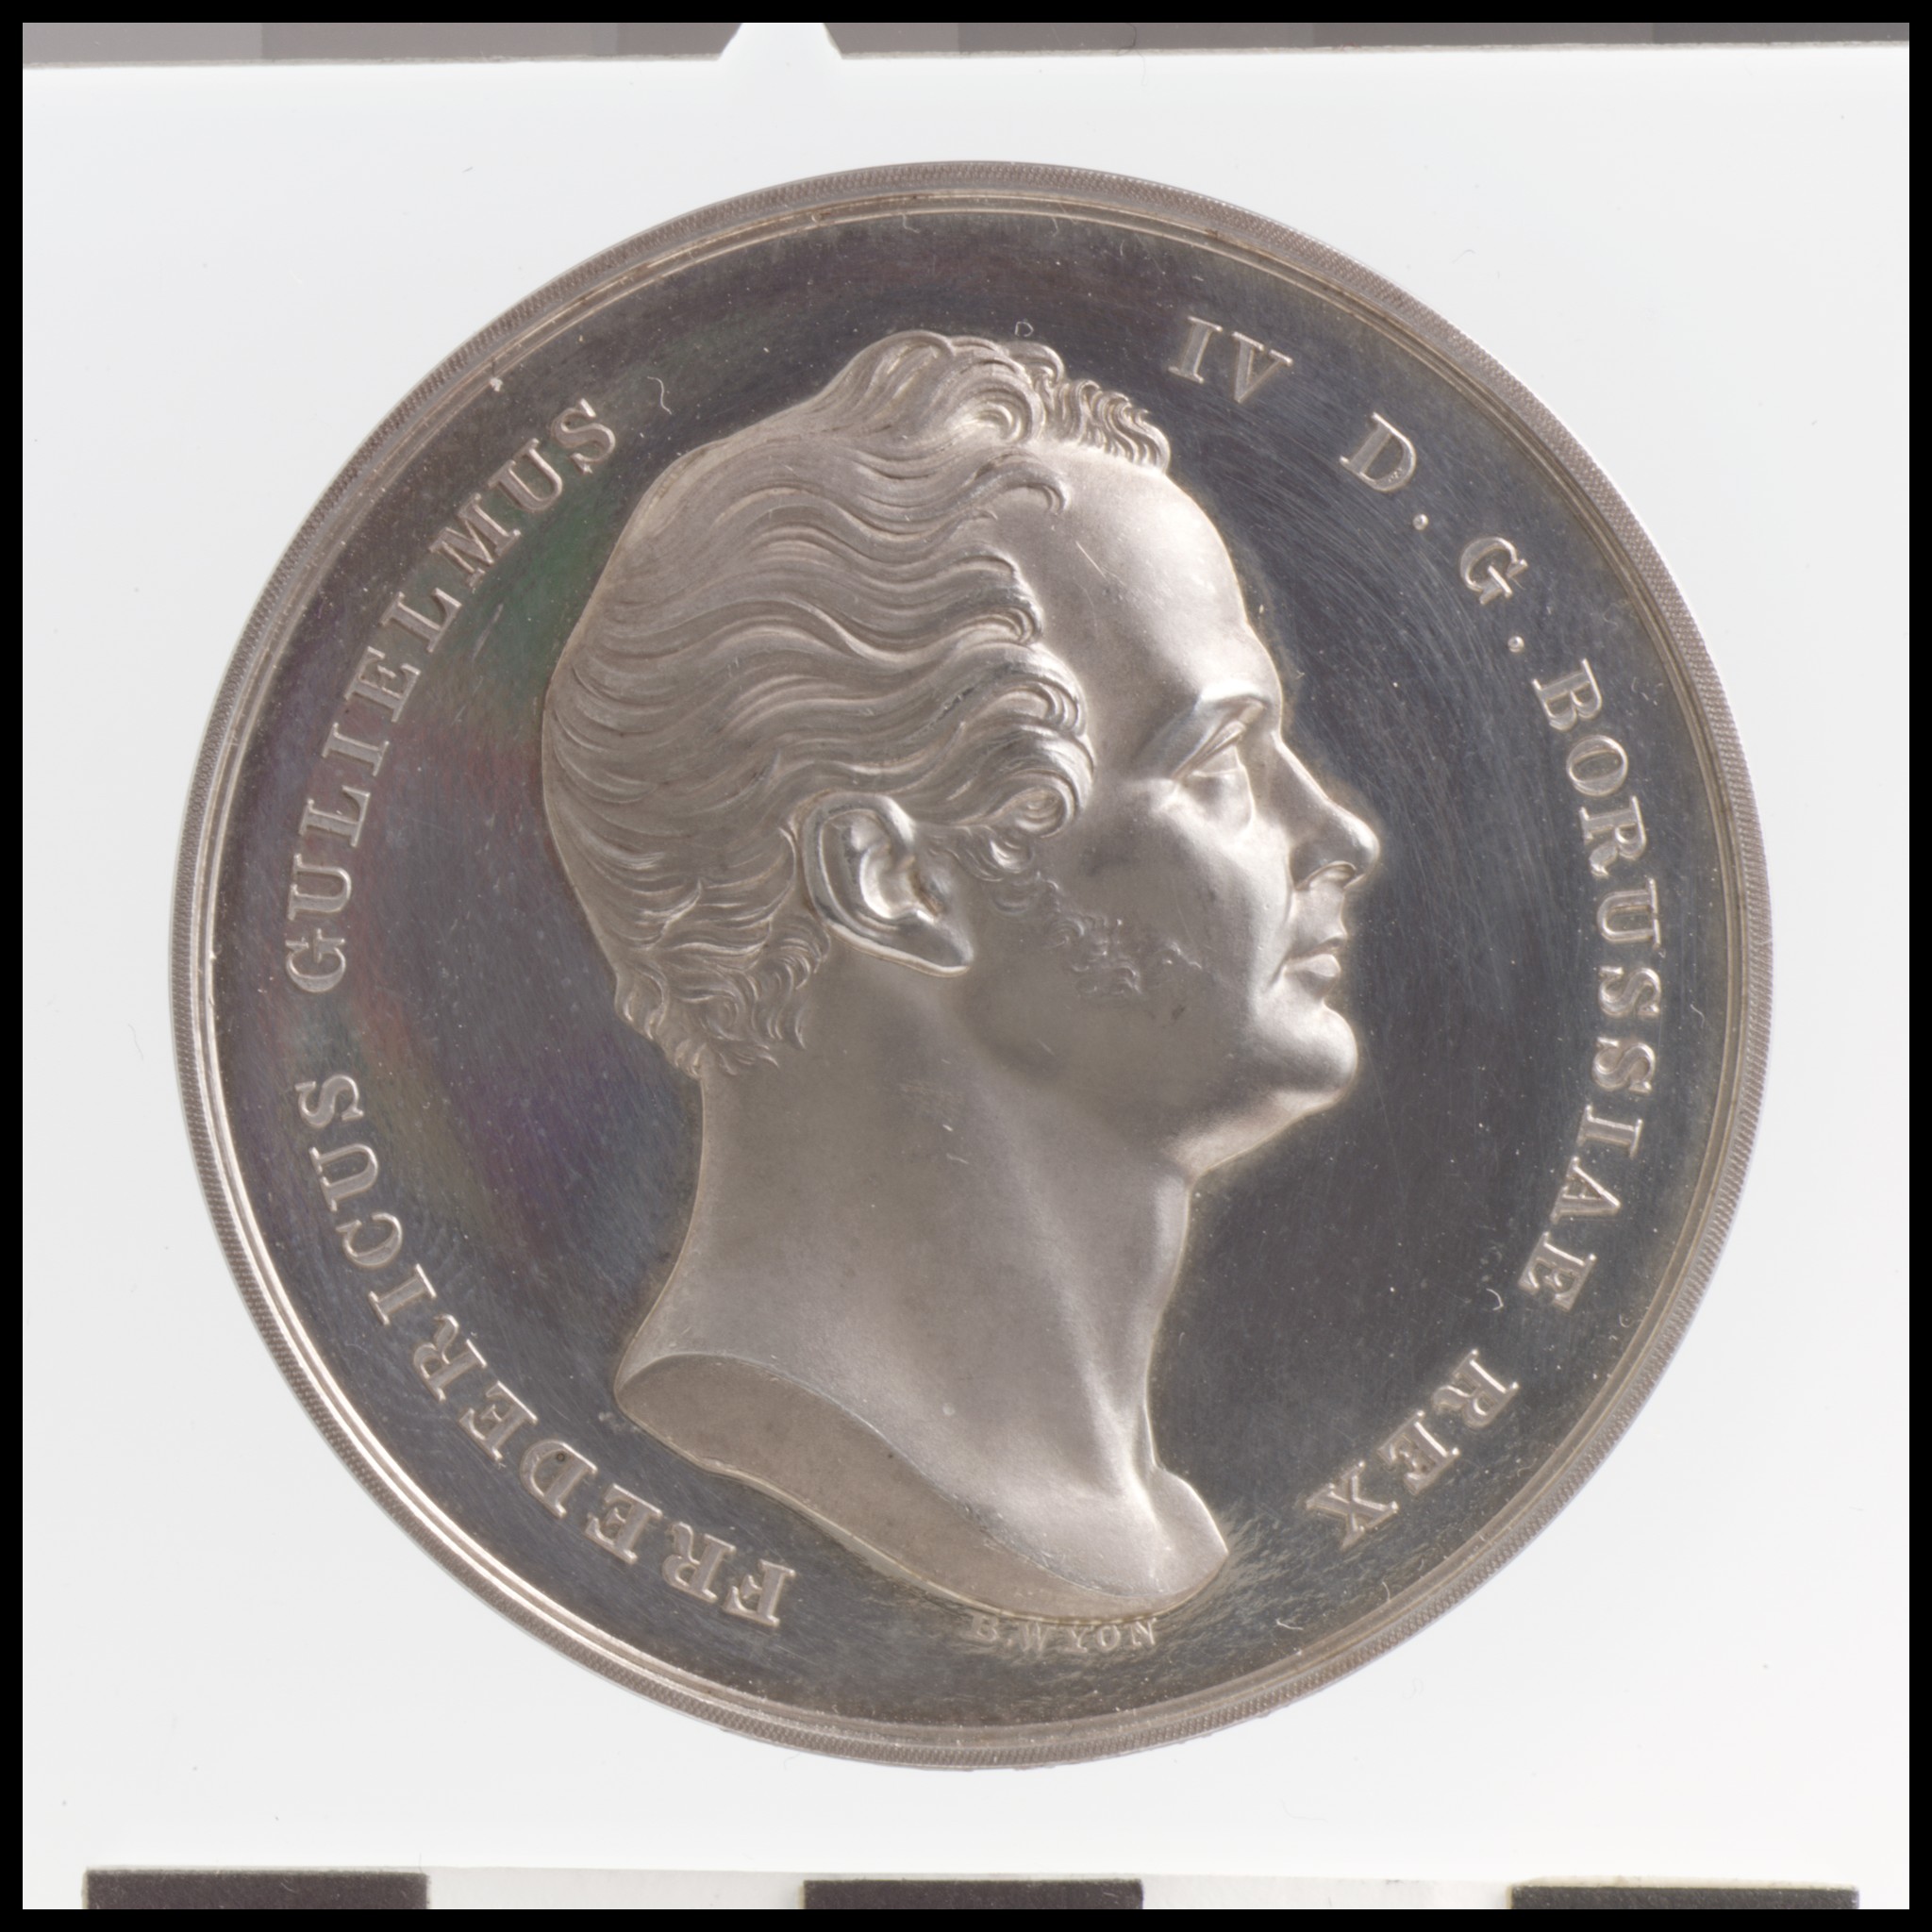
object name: medal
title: Friedrich Wilhelm IV's Visit to London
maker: benjamin wyon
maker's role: artist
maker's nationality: british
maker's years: 1802-1858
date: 1842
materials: silver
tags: men,profiles,coat of arms